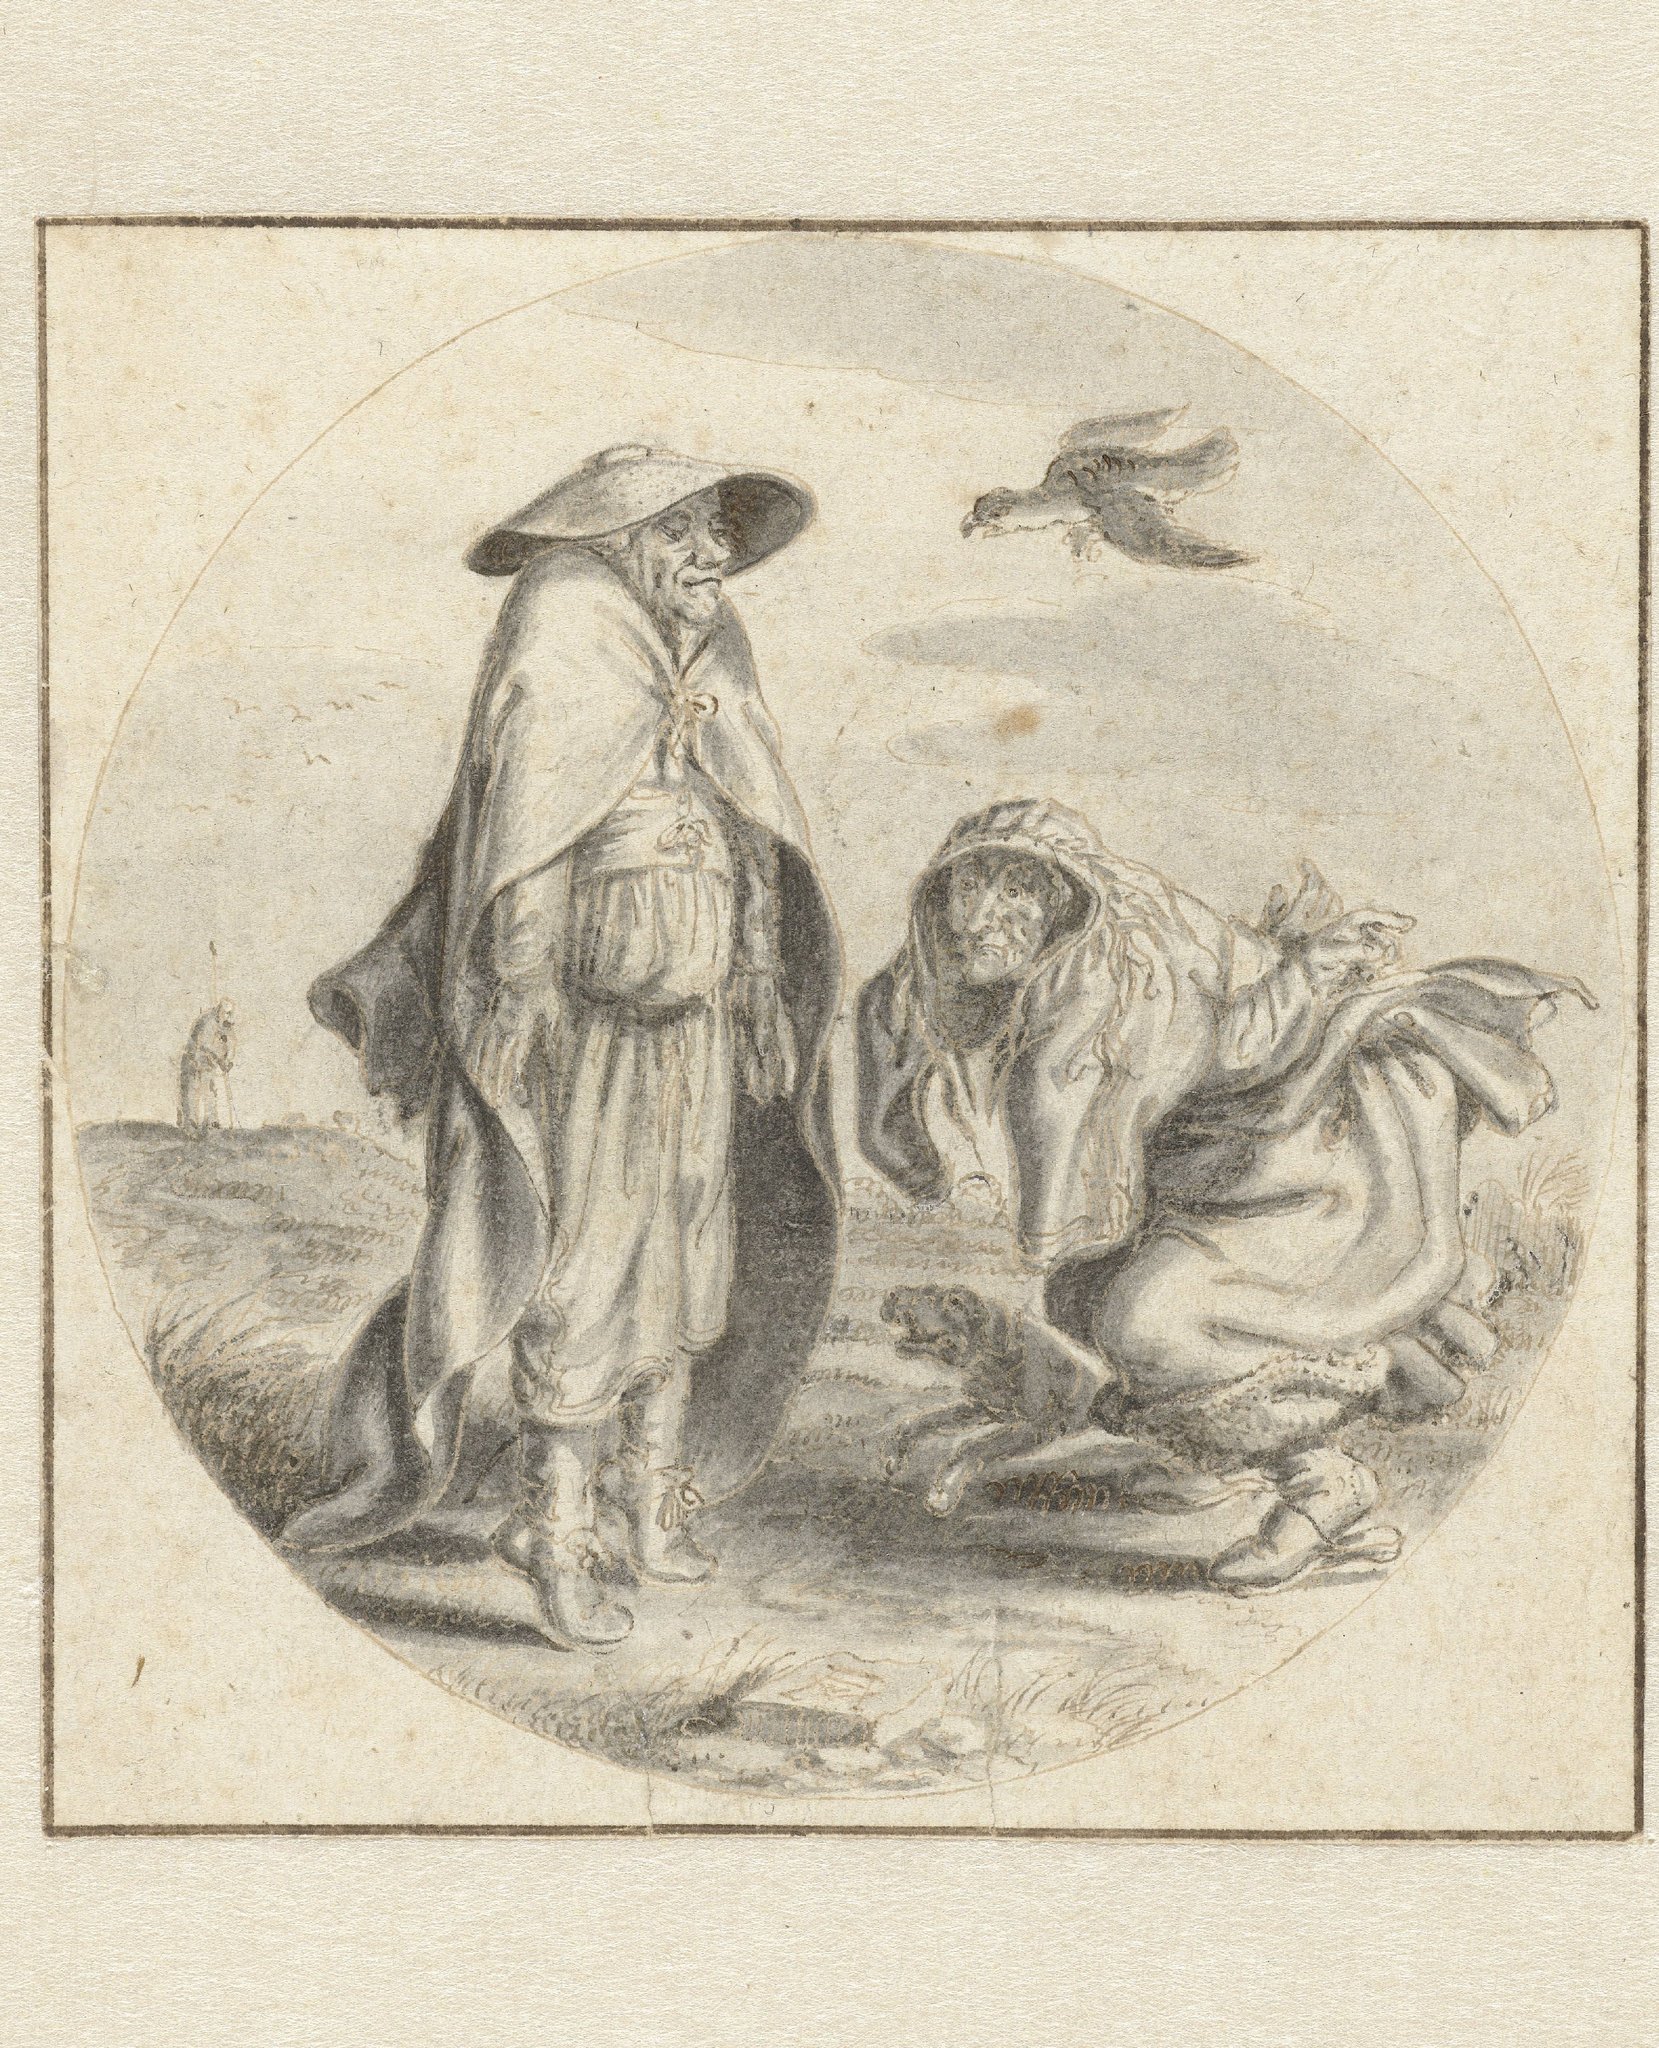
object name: drawing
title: Man and Woman Imitating Birds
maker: adriaen pietersz van de venne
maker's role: draughtsman, painter, print maker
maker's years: 1589-1662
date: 1618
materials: ink, paper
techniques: brush, pen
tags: farmers, farmers - aa - female farmer, farmer's wife, birds (+ egg-laying), man disguised as animal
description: Pendant van 'Een man en een vrouw die vogels nadoen', inventarisnummer RP-T-1898-A-4052.